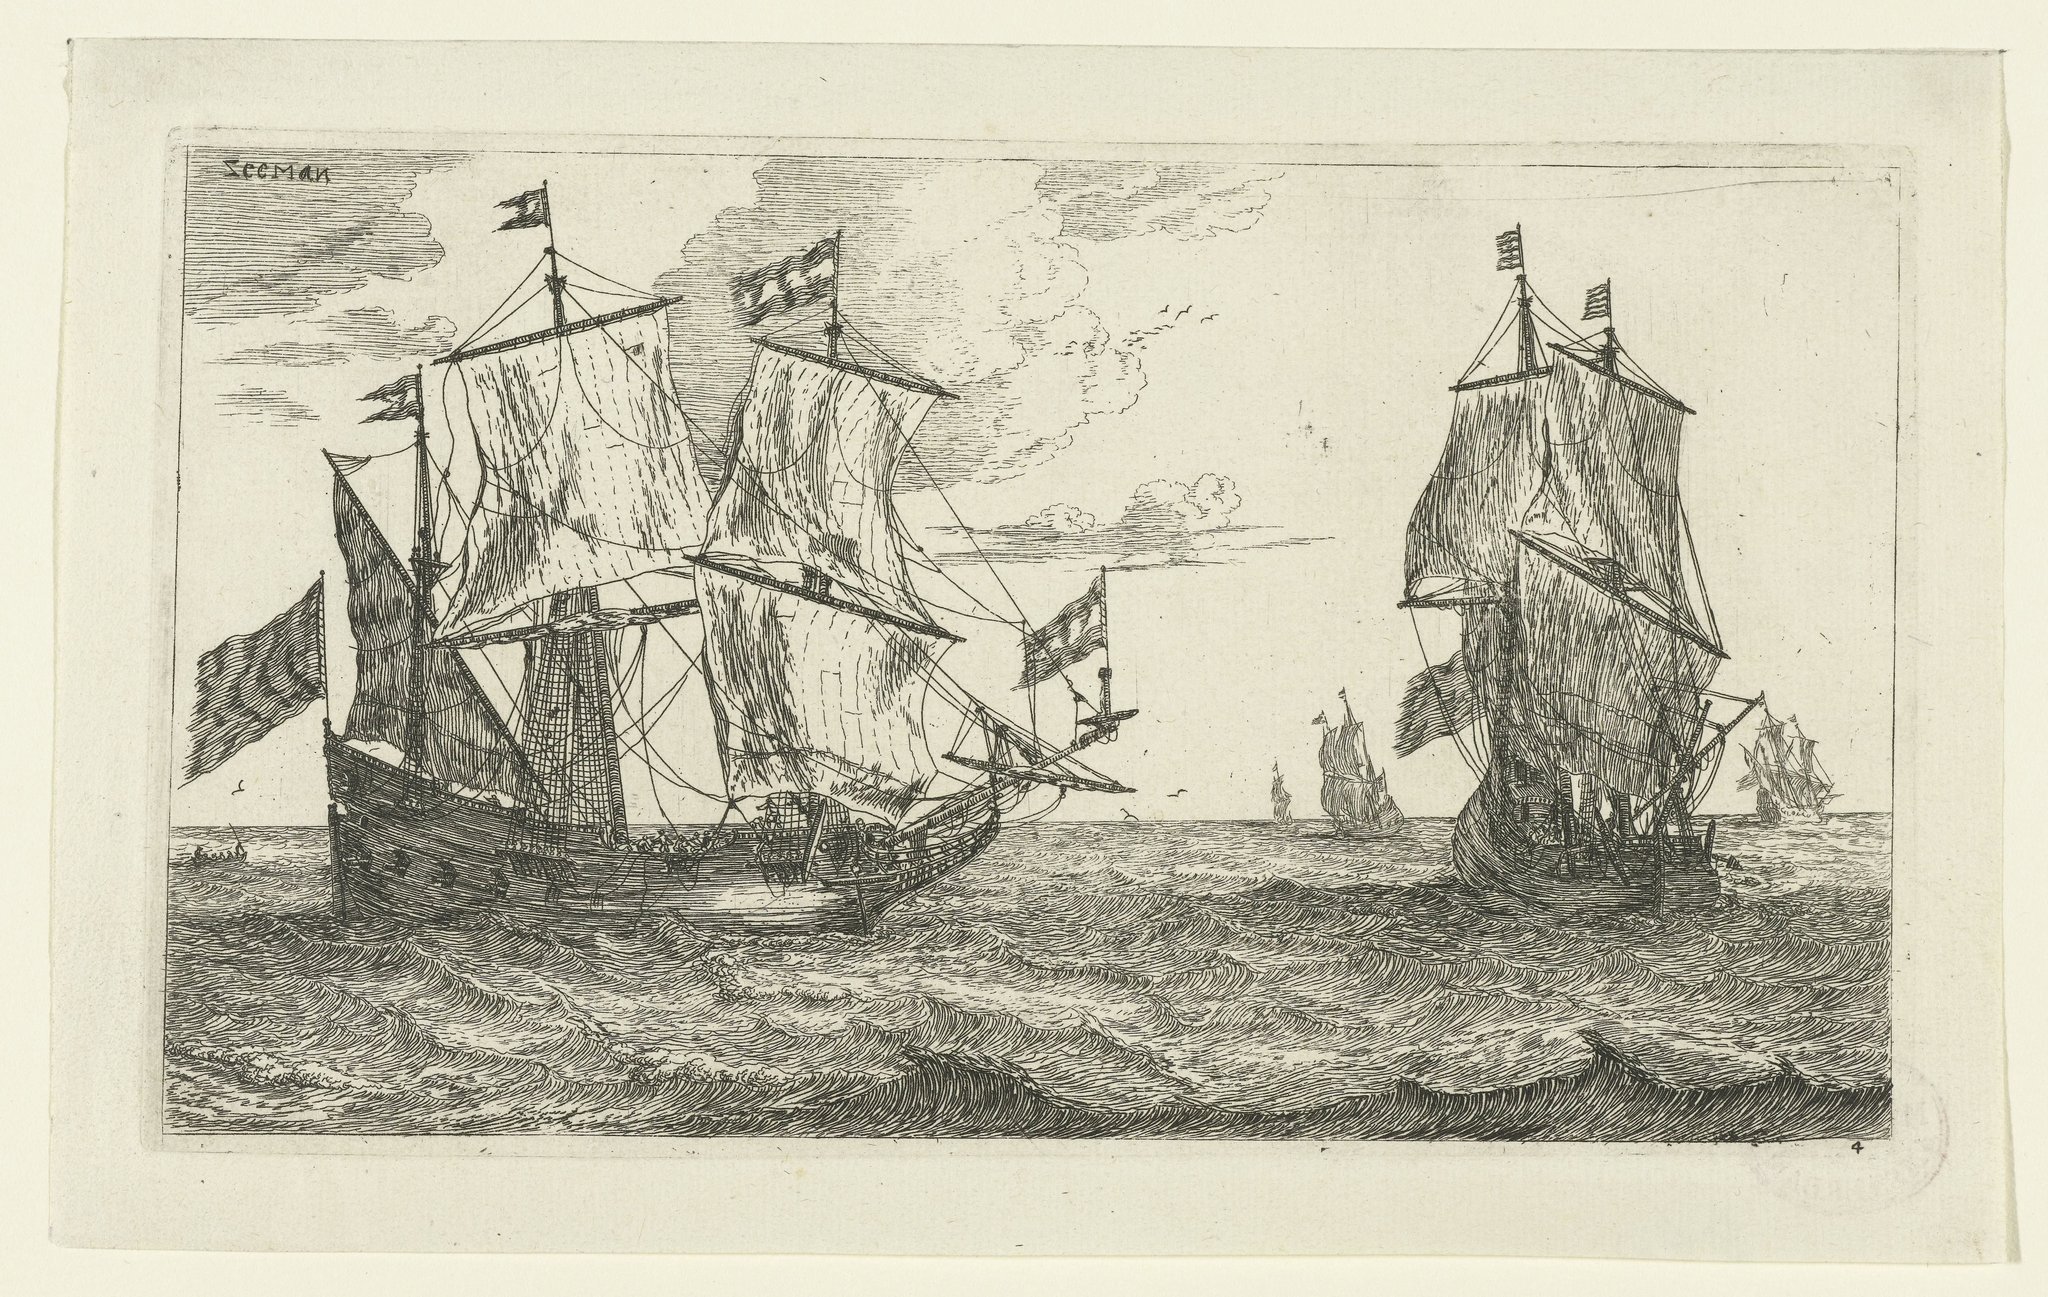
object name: print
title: Twee grote zeilschepen met vlaggen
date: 1652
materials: paper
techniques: etching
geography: netherlands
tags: sailing-ship, sailing-boat (with name)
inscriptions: collector's mark: Lugt 12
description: Twee fluitschepen met gehesen zeilen en vlaggen.